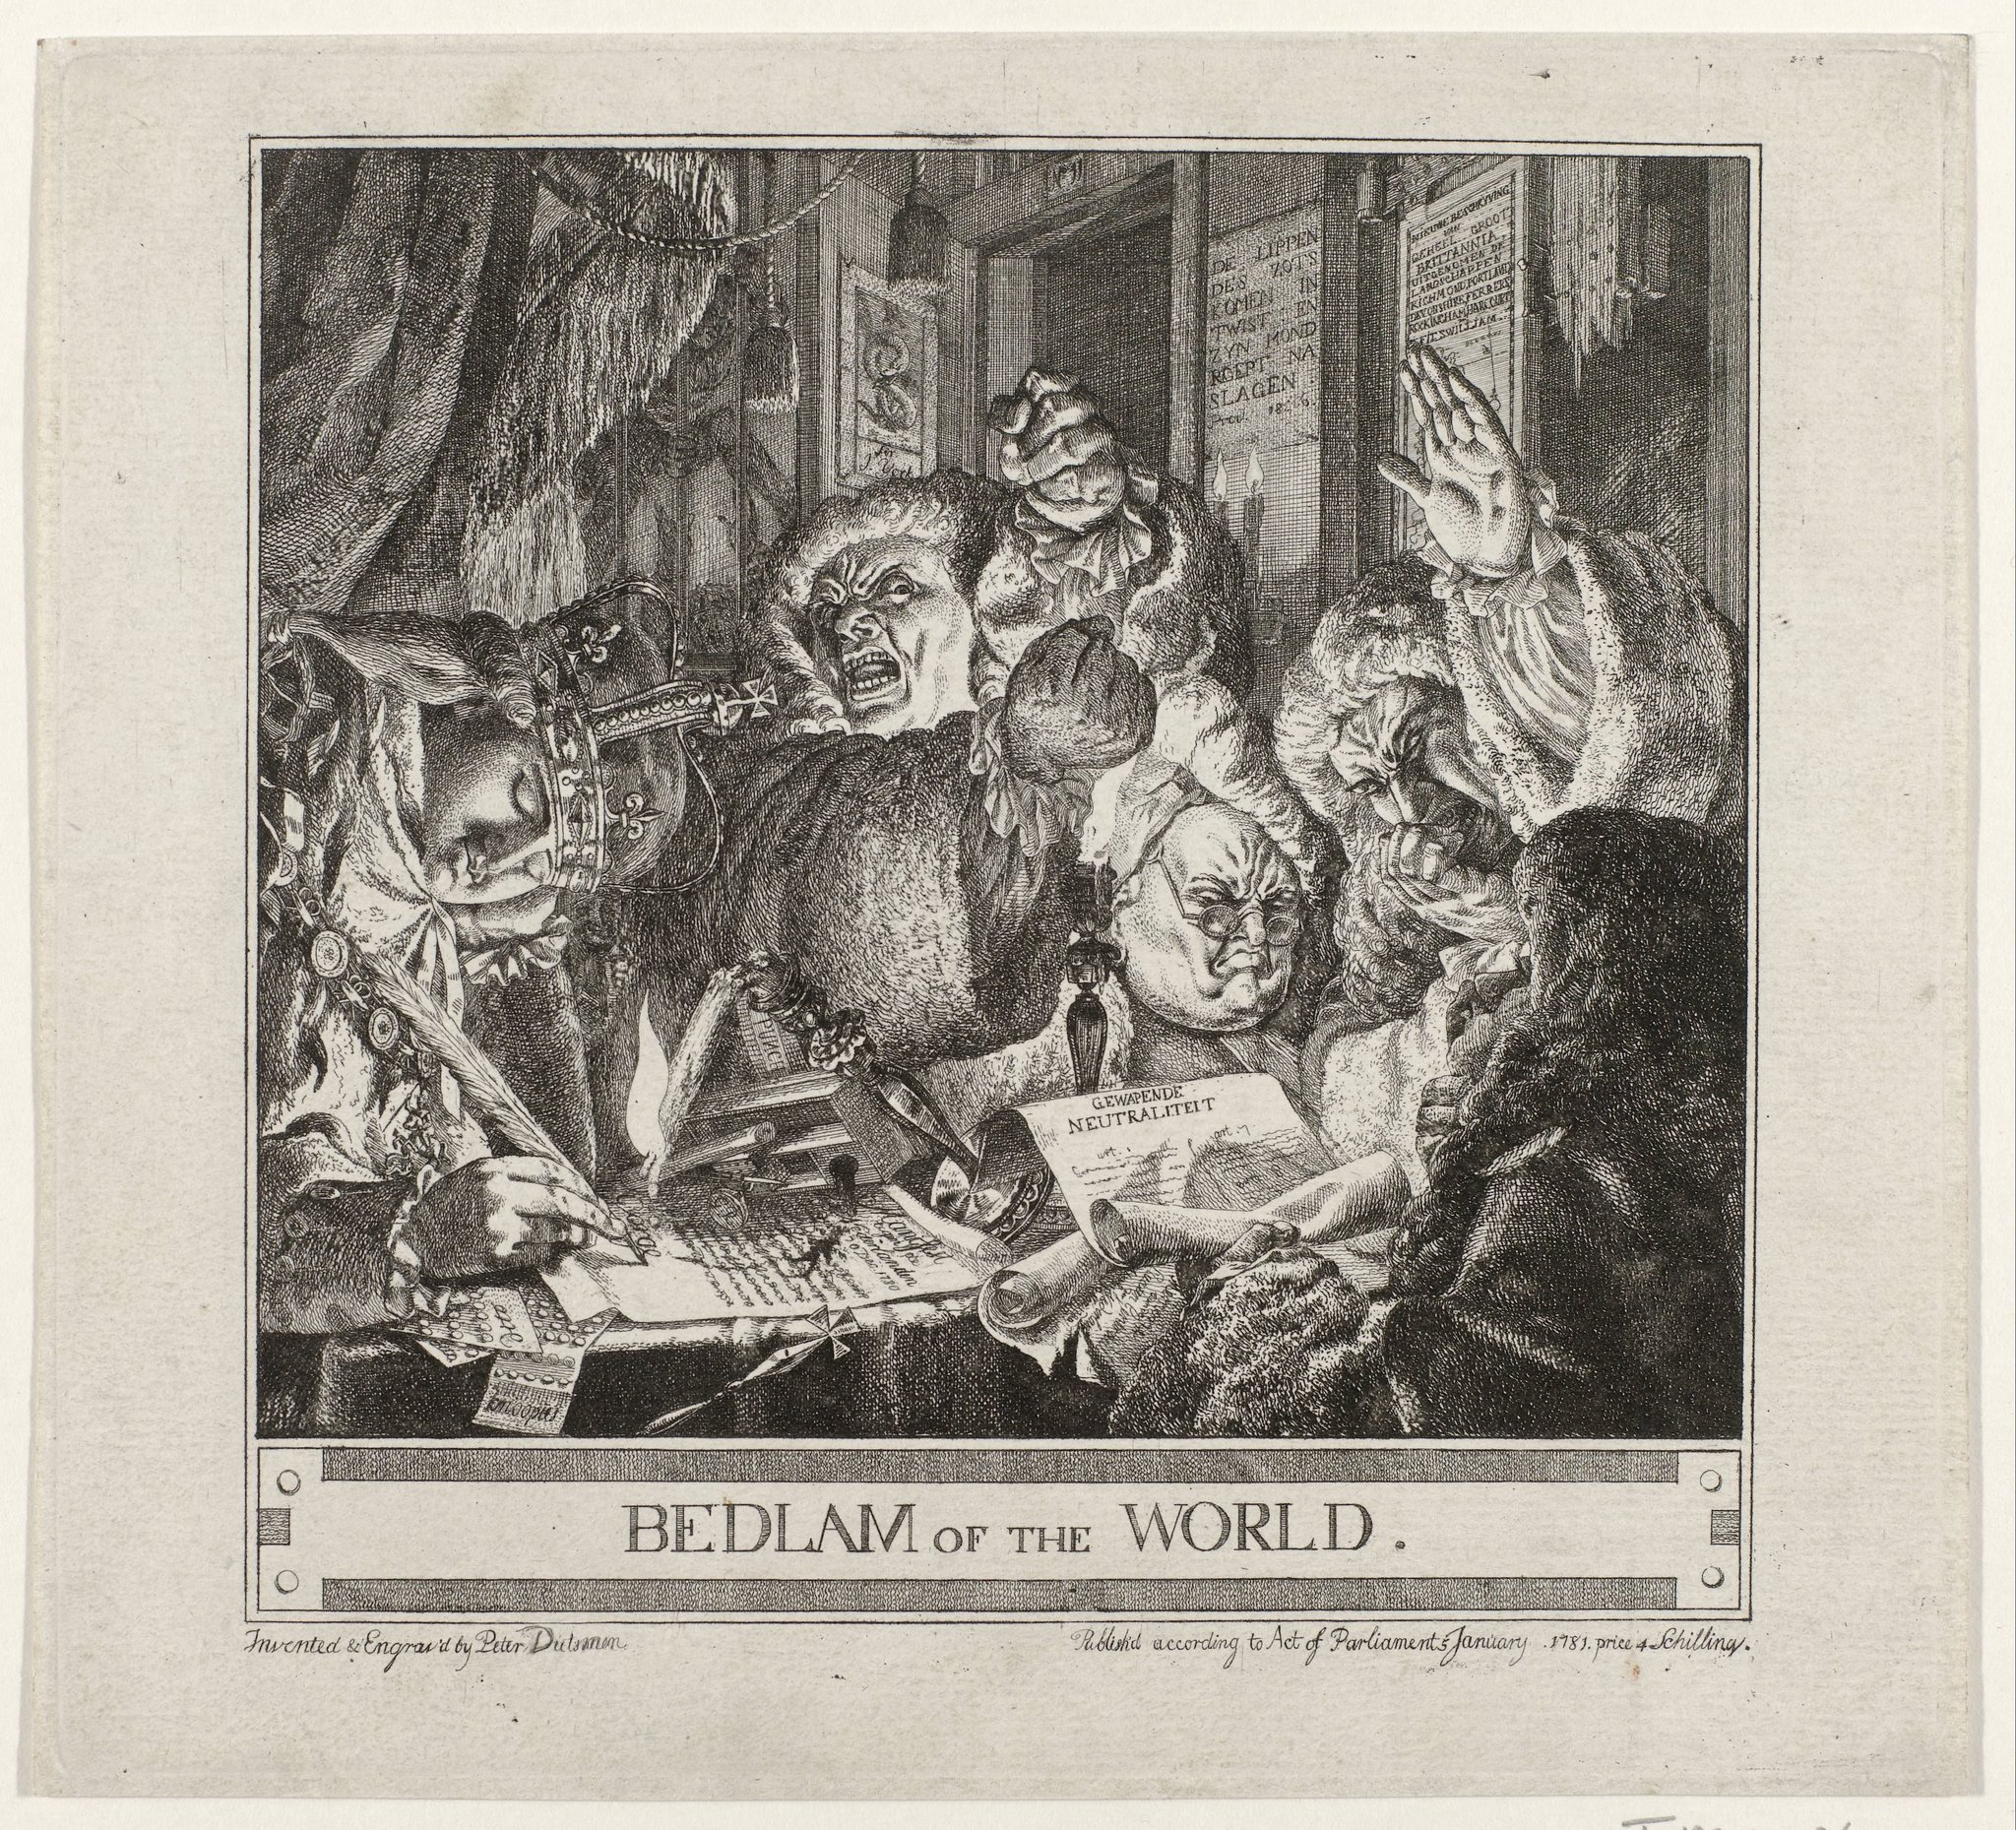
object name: print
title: Spotprent op de Engelse oorlogsverklaring aan de Republiek, 1780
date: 1701-1781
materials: paper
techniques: etching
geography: northern netherlands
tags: london, george iii (koning van het verenigd koninkrijk), declaration of war, fourth anglo-dutch war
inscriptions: collector's mark: Lugt 2228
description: Spotprent op de Engelse oorlogsverklaring. Koning George III tekent al slapende bij het licht van een omvallende kaars op 20 december 1780 de oorlogsverklaring aan de Republiek. Rechts een man met een document over de Gewapende Neutraliteit, tegenover hem drie andere woedende lords.